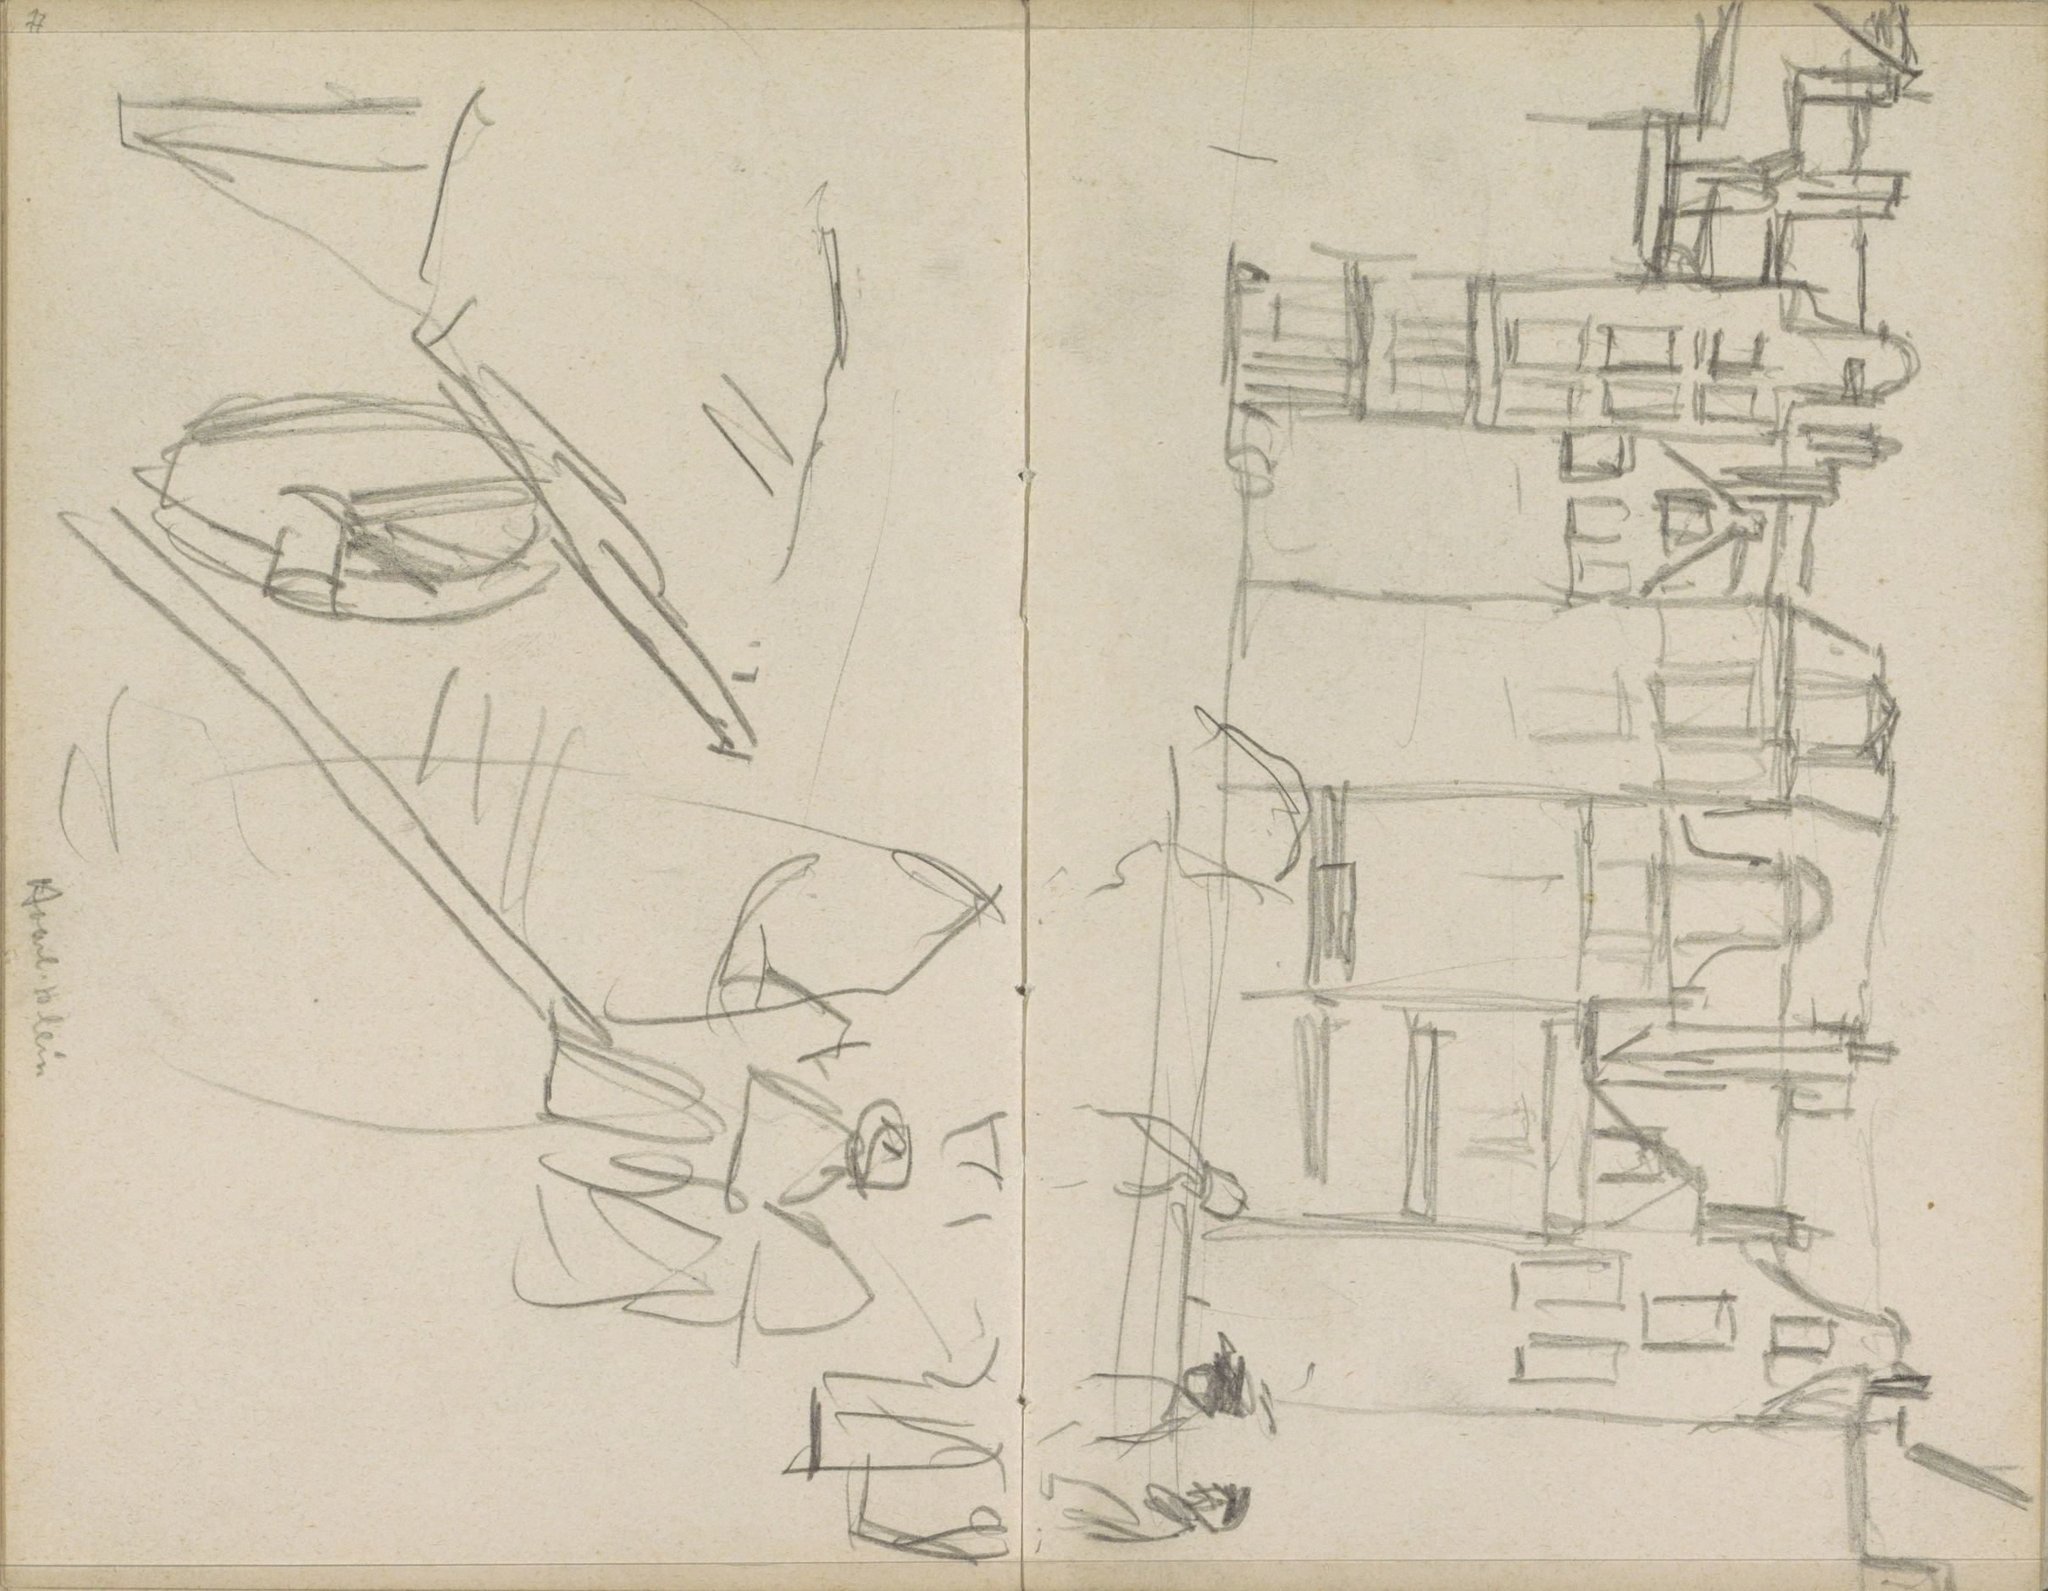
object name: sketchbook leaf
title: Gezicht op het Haarlemmerplein te Amsterdam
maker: george hendrik breitner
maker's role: draughtsman, painter, print maker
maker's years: 1857-1923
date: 1886-1903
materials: paper, pencil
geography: amsterdam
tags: hand-cart, urban housing, square, place, circus, etc. (+ city(-scape) with figures, staffage)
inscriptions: annotation: ‘Haarl. plein’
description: Vooraan een kar en figuren. Pagina 77 en pagina 78 uit een schetsboek met 46 bladen.